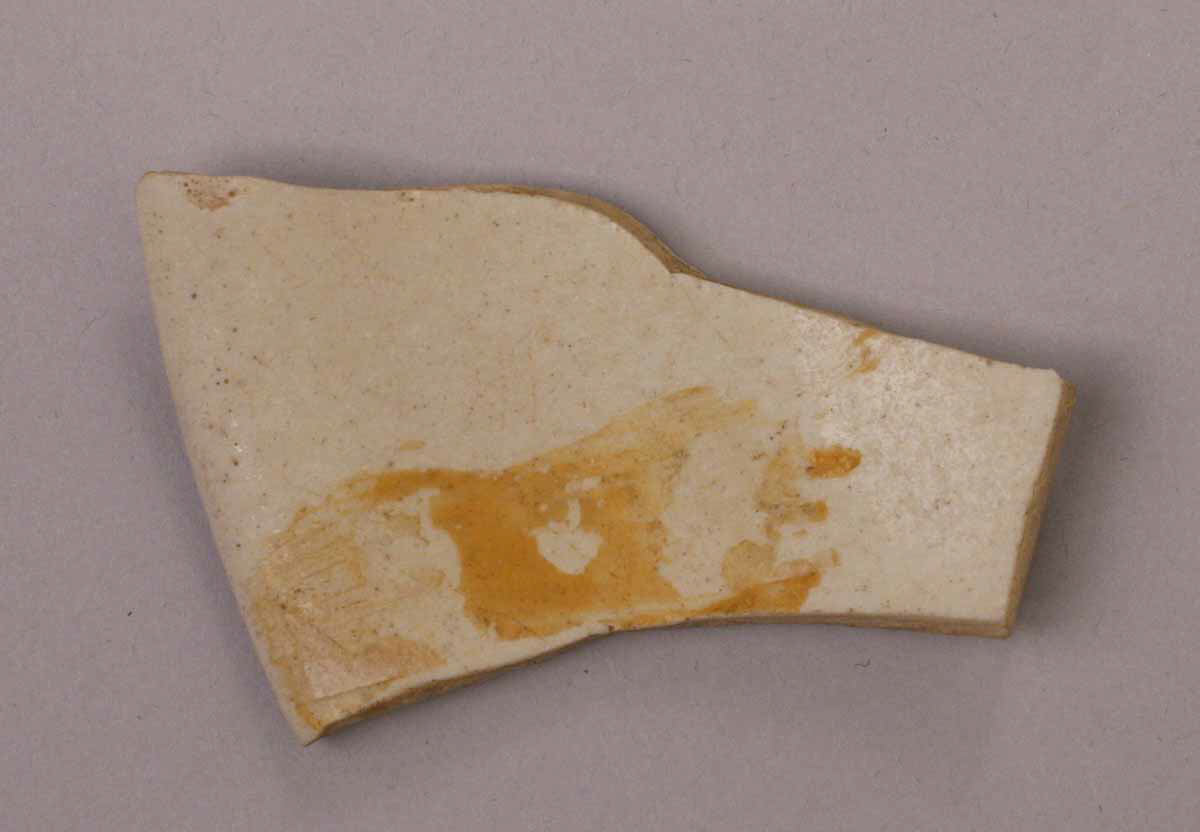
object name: fragment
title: Ceramic Fragment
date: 801-1000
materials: earthenware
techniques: glazing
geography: saudi arabia